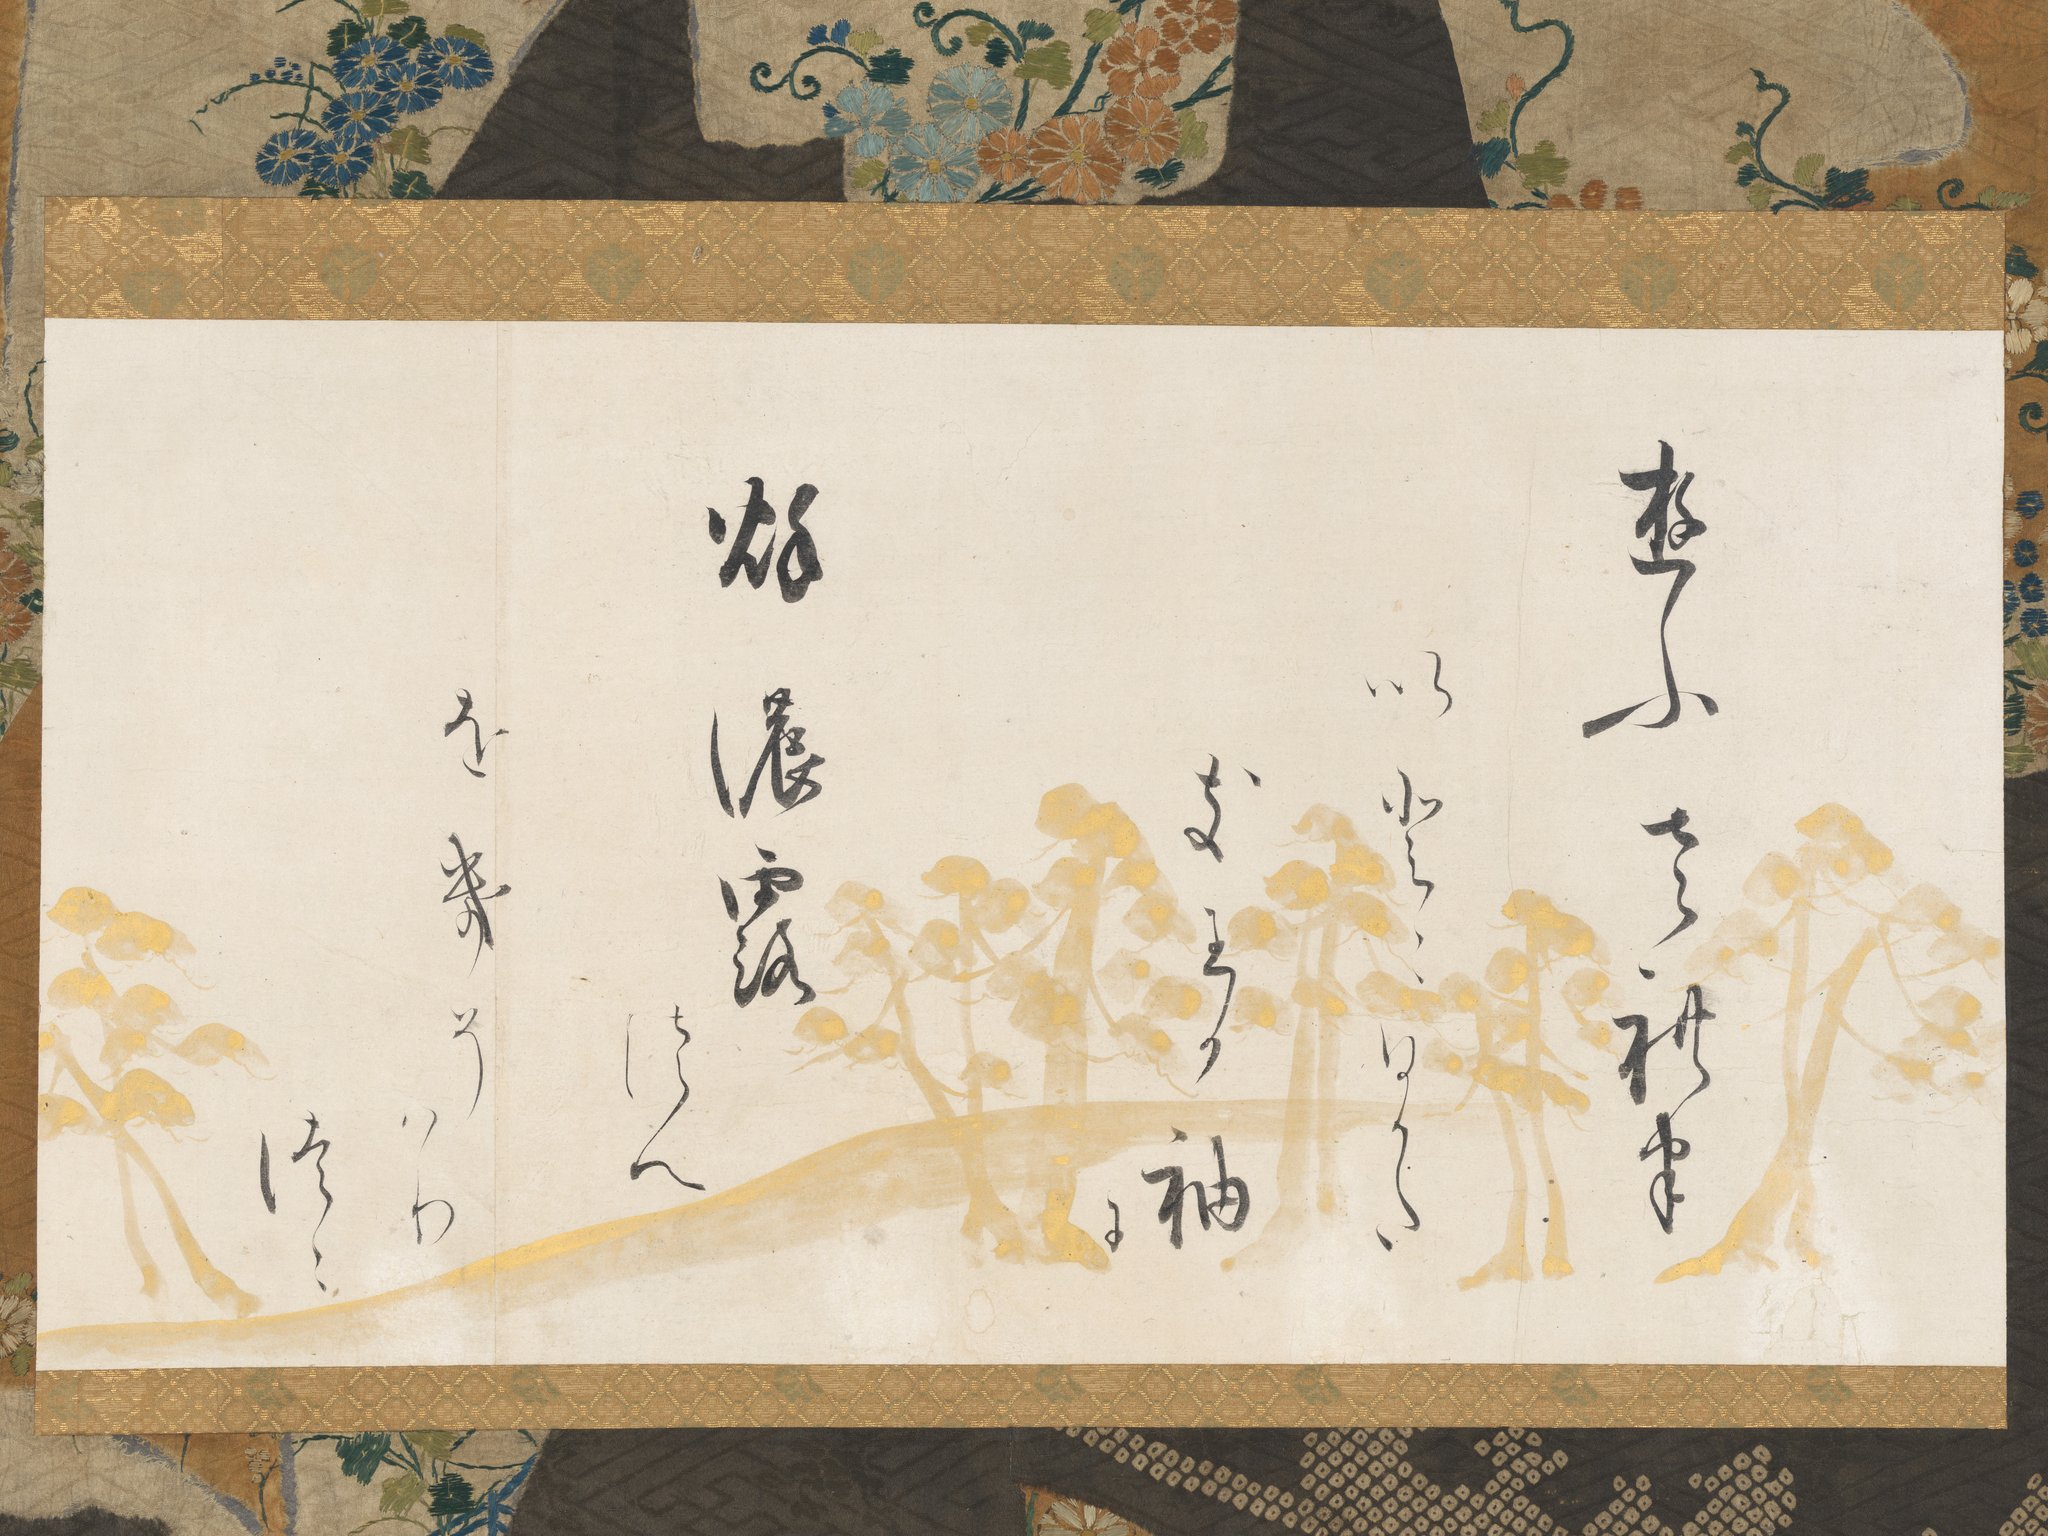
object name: hanging scroll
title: Section of a Handscroll with Waka and Underpainting of Pines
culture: japanese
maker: hon'ami kōetsu 本阿弥光悦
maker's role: calligrapher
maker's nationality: japanese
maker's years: 1558-1637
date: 1601-1633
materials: gold, ink, paper